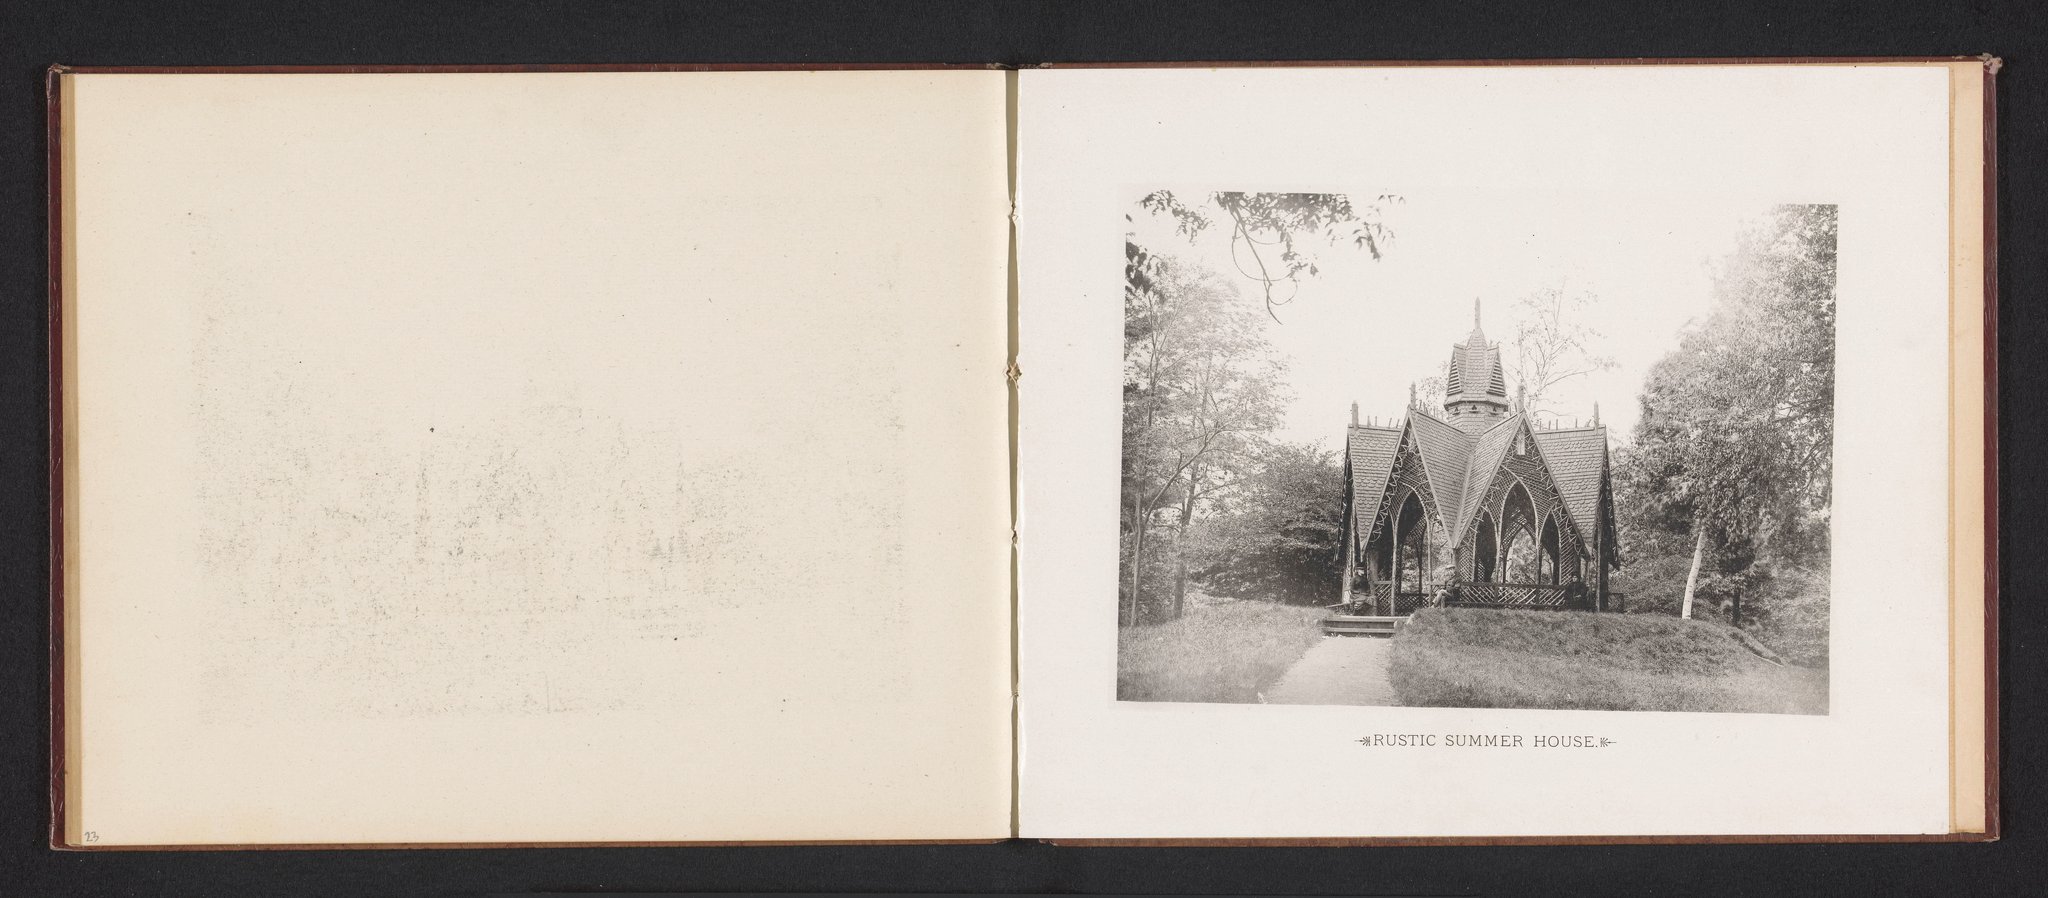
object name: page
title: Rustic summer House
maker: Anonymous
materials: paper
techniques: photograph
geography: montreal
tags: cemetery, park-like burying ground